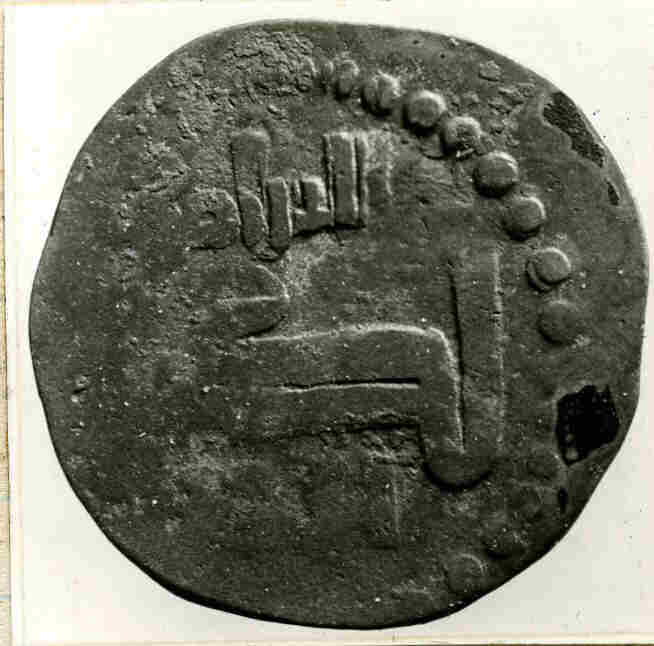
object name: coin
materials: copper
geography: iran